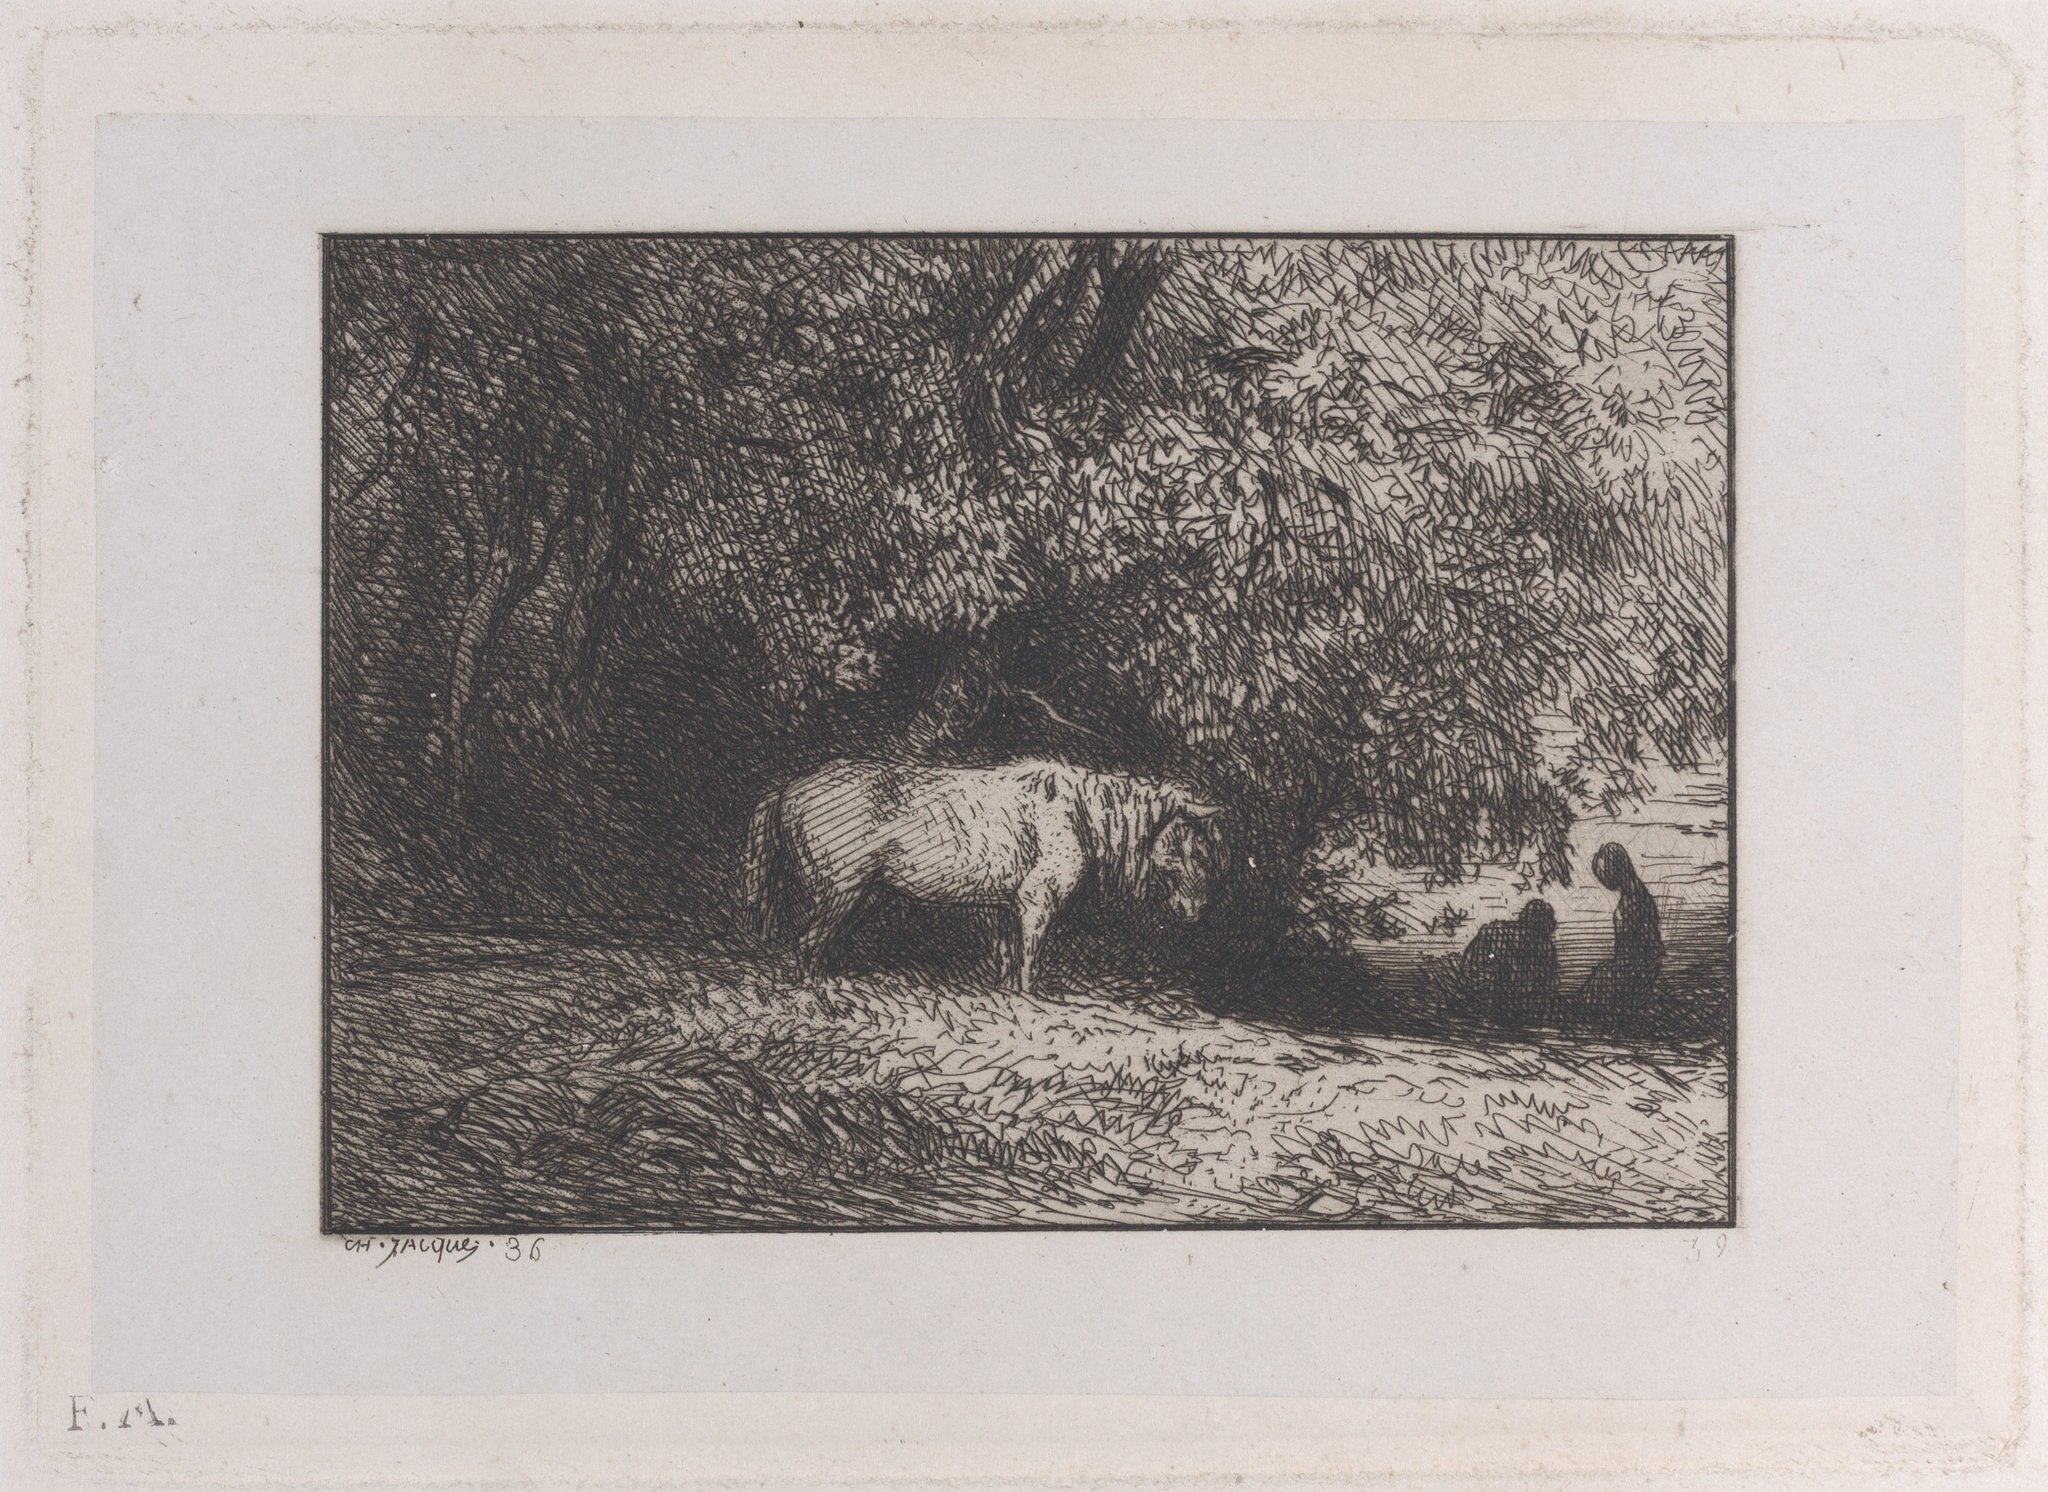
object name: print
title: Horse Under a Tree Branch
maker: charles émile jacque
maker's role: artist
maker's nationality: french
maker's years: 1813-1894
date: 1846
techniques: etching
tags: horses